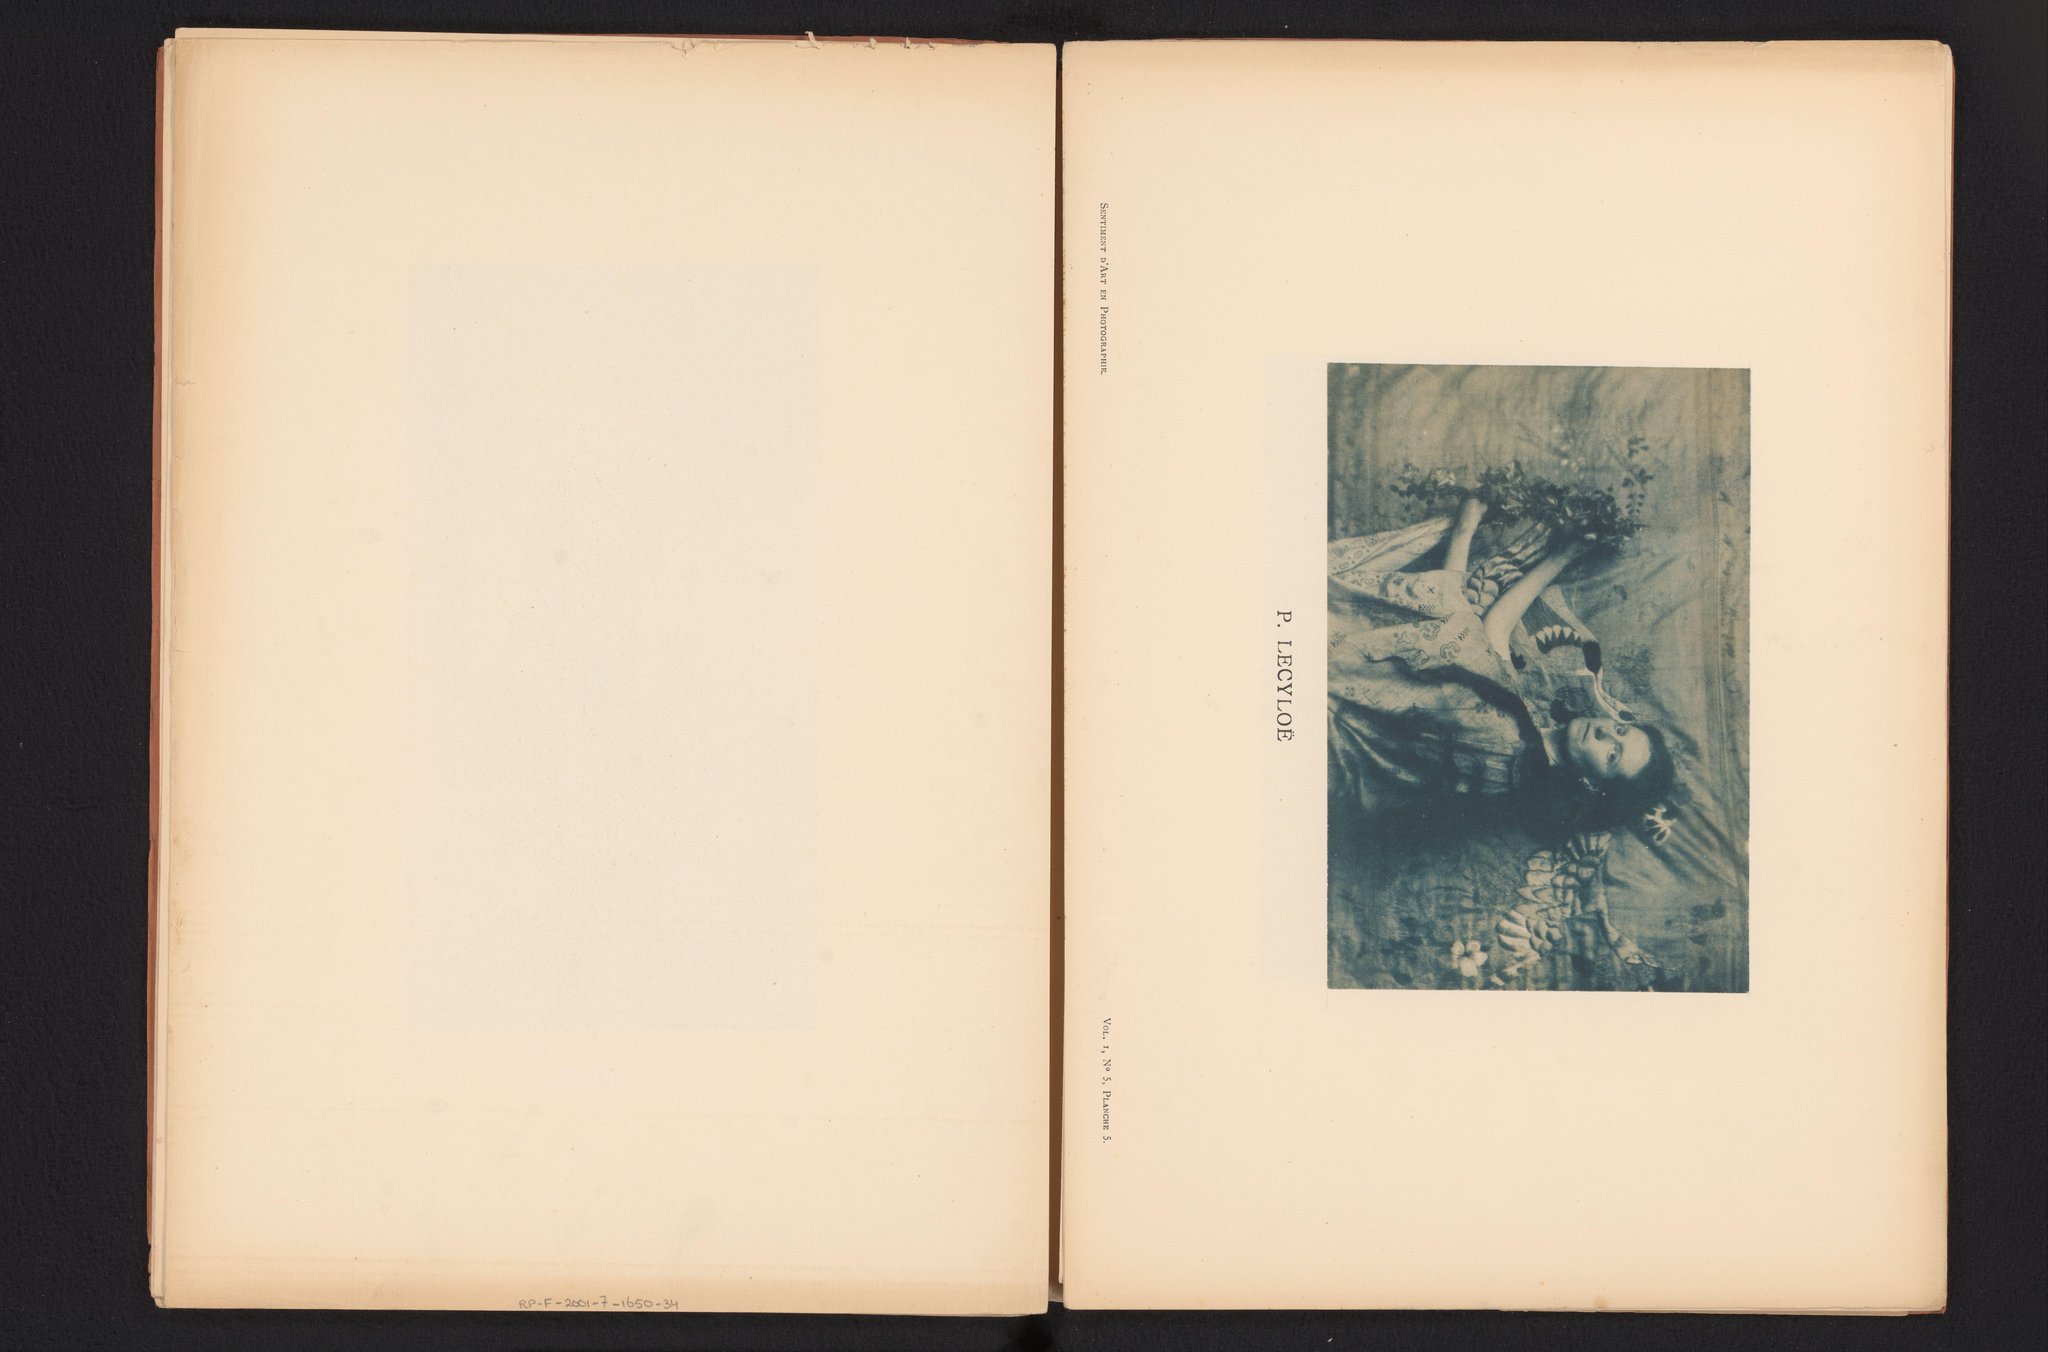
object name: photomechanical print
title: Sentiment d'Art en Photographie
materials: paper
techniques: photograph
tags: flowers, historical persons - bb - woman, tapestry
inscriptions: number: ‘Vol. 1, No 5, Planche 5.’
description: Deze prent maakt deel uit van 8 omslagen met 22 tekstbladen en 89 prenten op losse bladen in en tussen de omslagen.